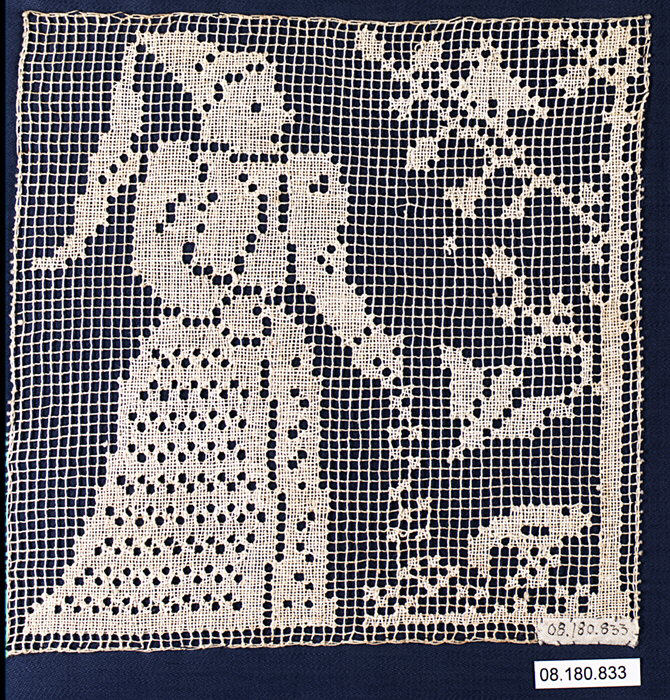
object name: square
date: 1801-1900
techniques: embroidery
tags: birds,women